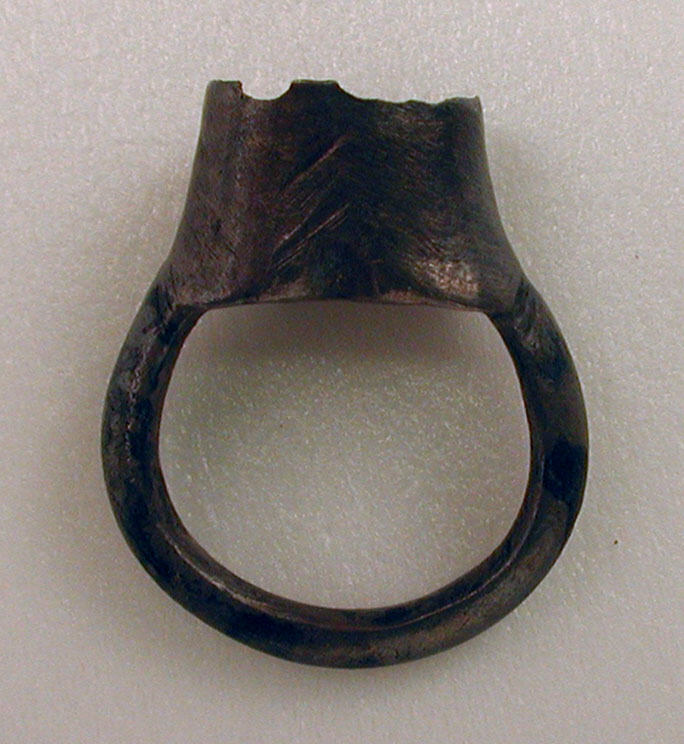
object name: ring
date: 801-1000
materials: silver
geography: iran